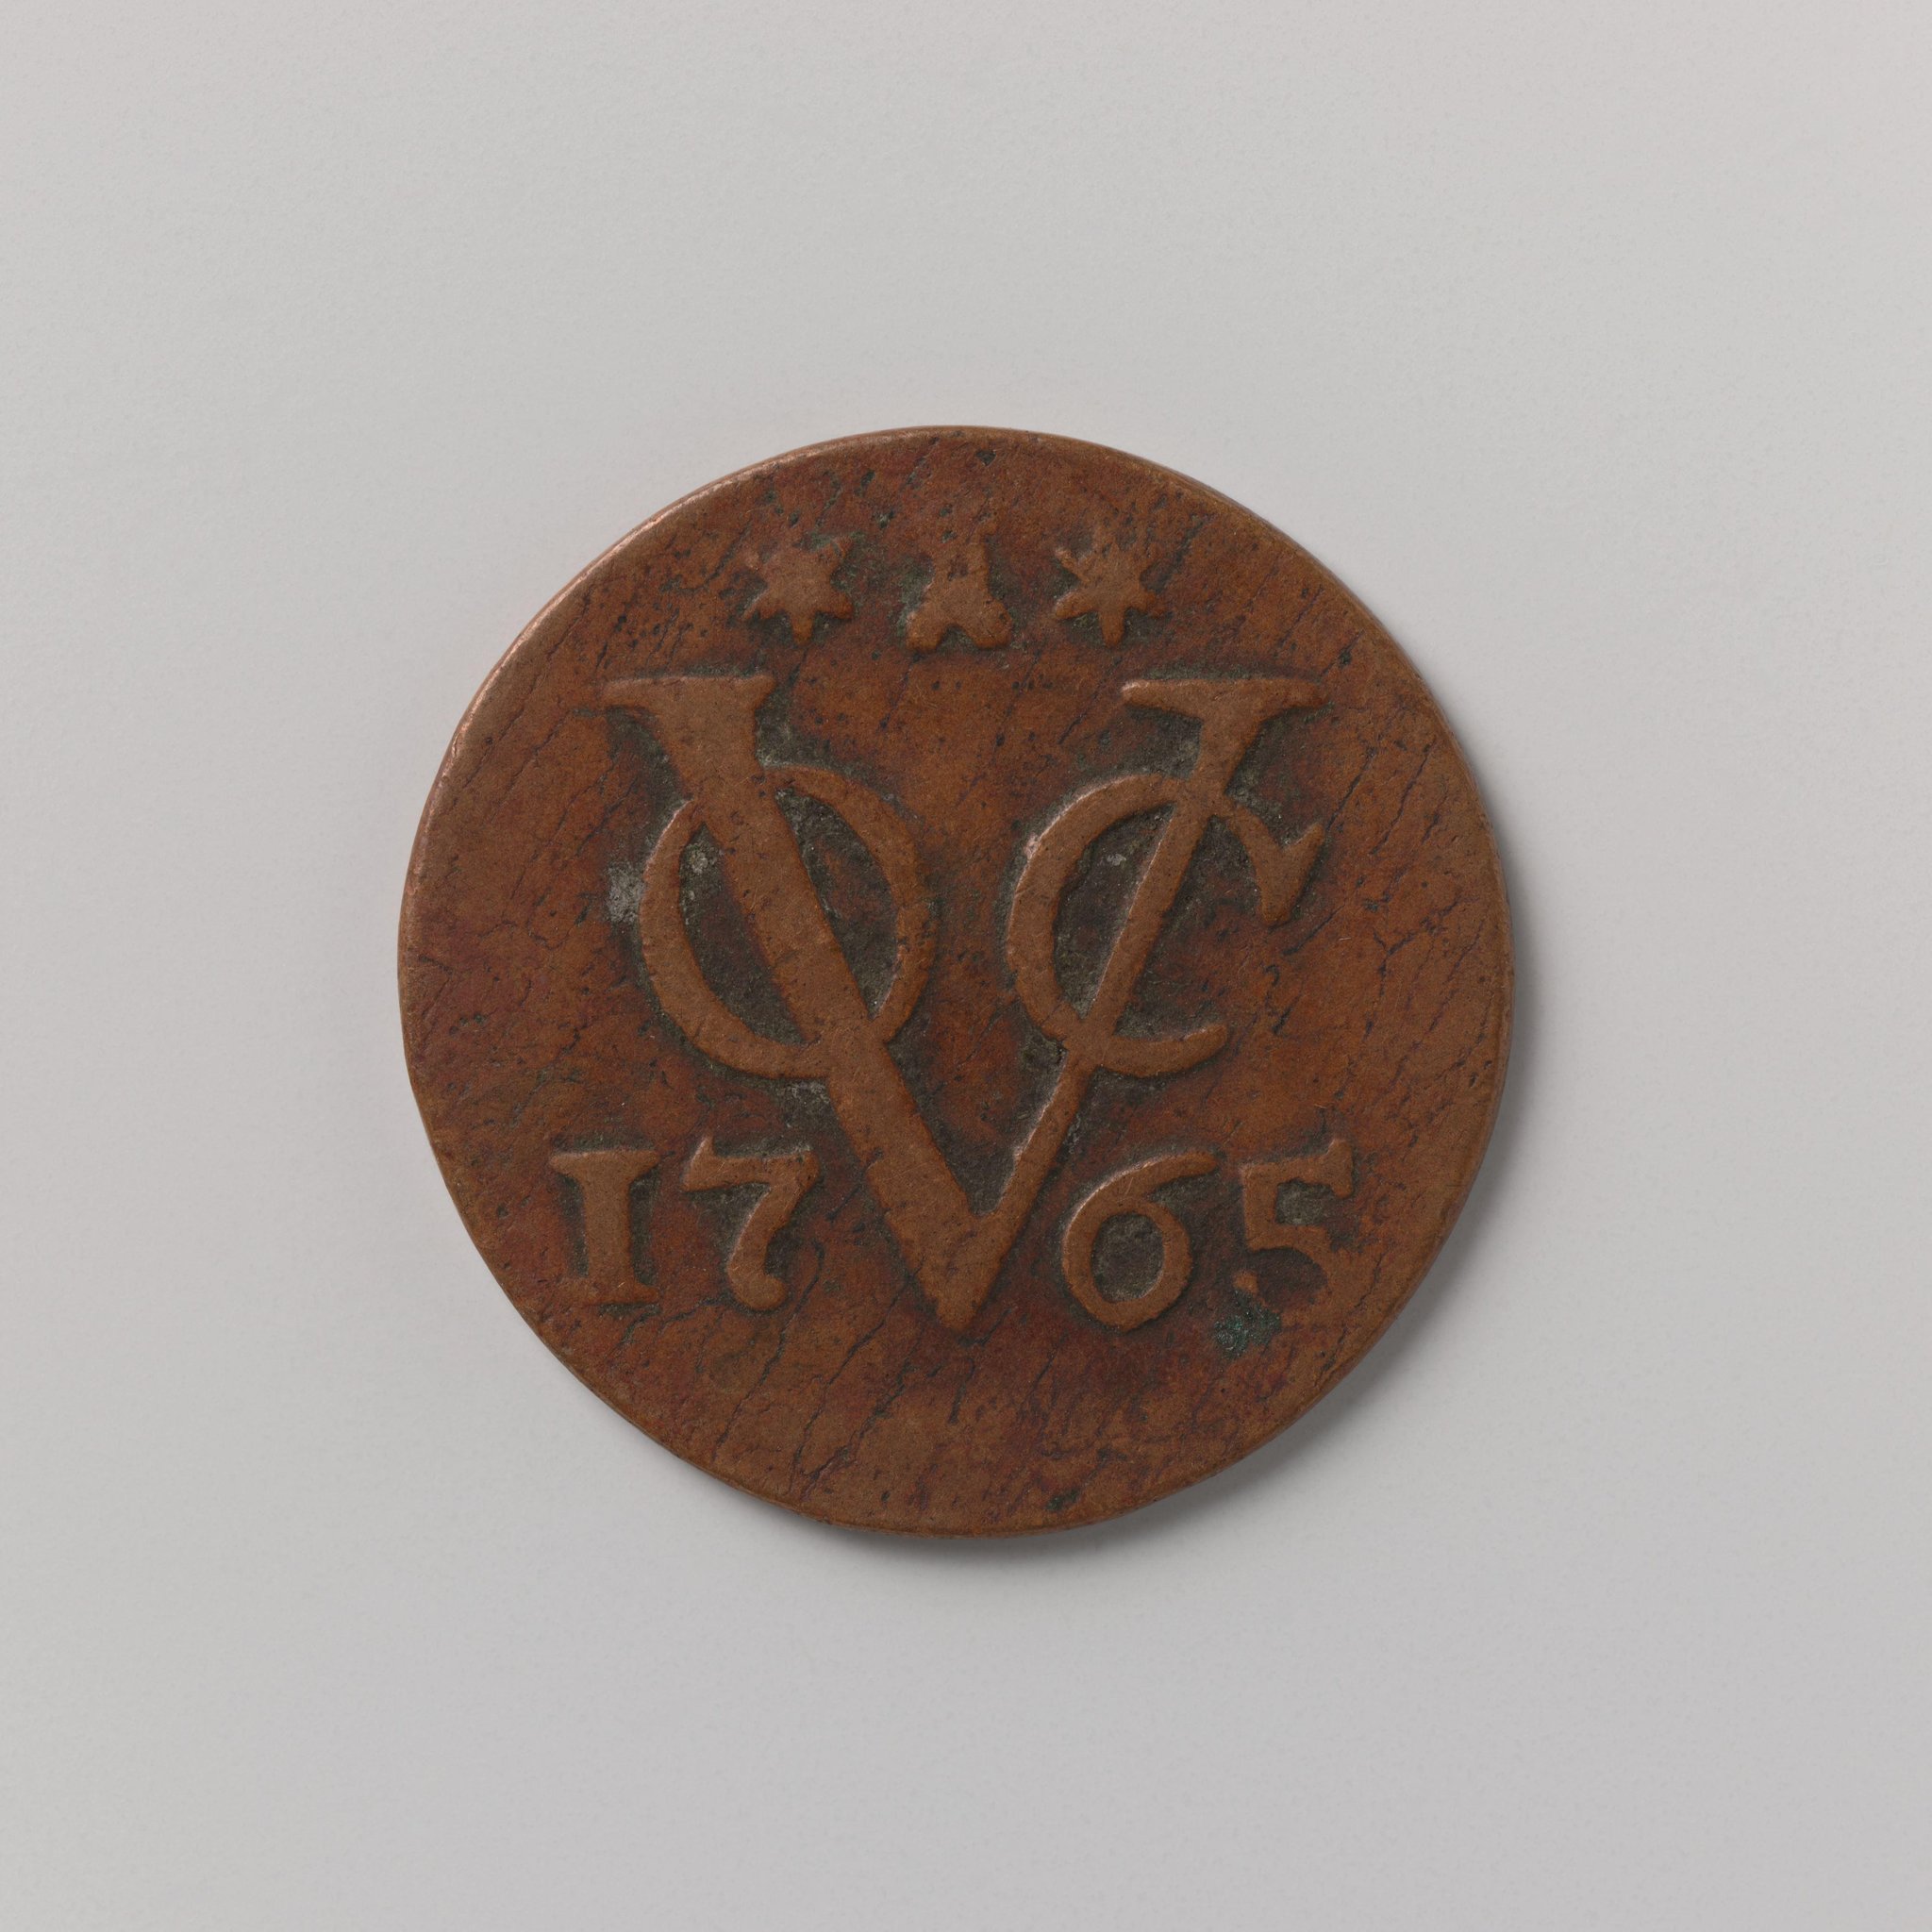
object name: coin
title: VOC, duit Zeeland, 1765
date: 1765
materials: copper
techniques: striking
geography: middelburg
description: Koperen munt. Voorzijde: gekroond wapenschild van Zeeland. Keerzijde: monogram van de VOC, waarboven muntteken en waaronder jaartal. Gladde rand.